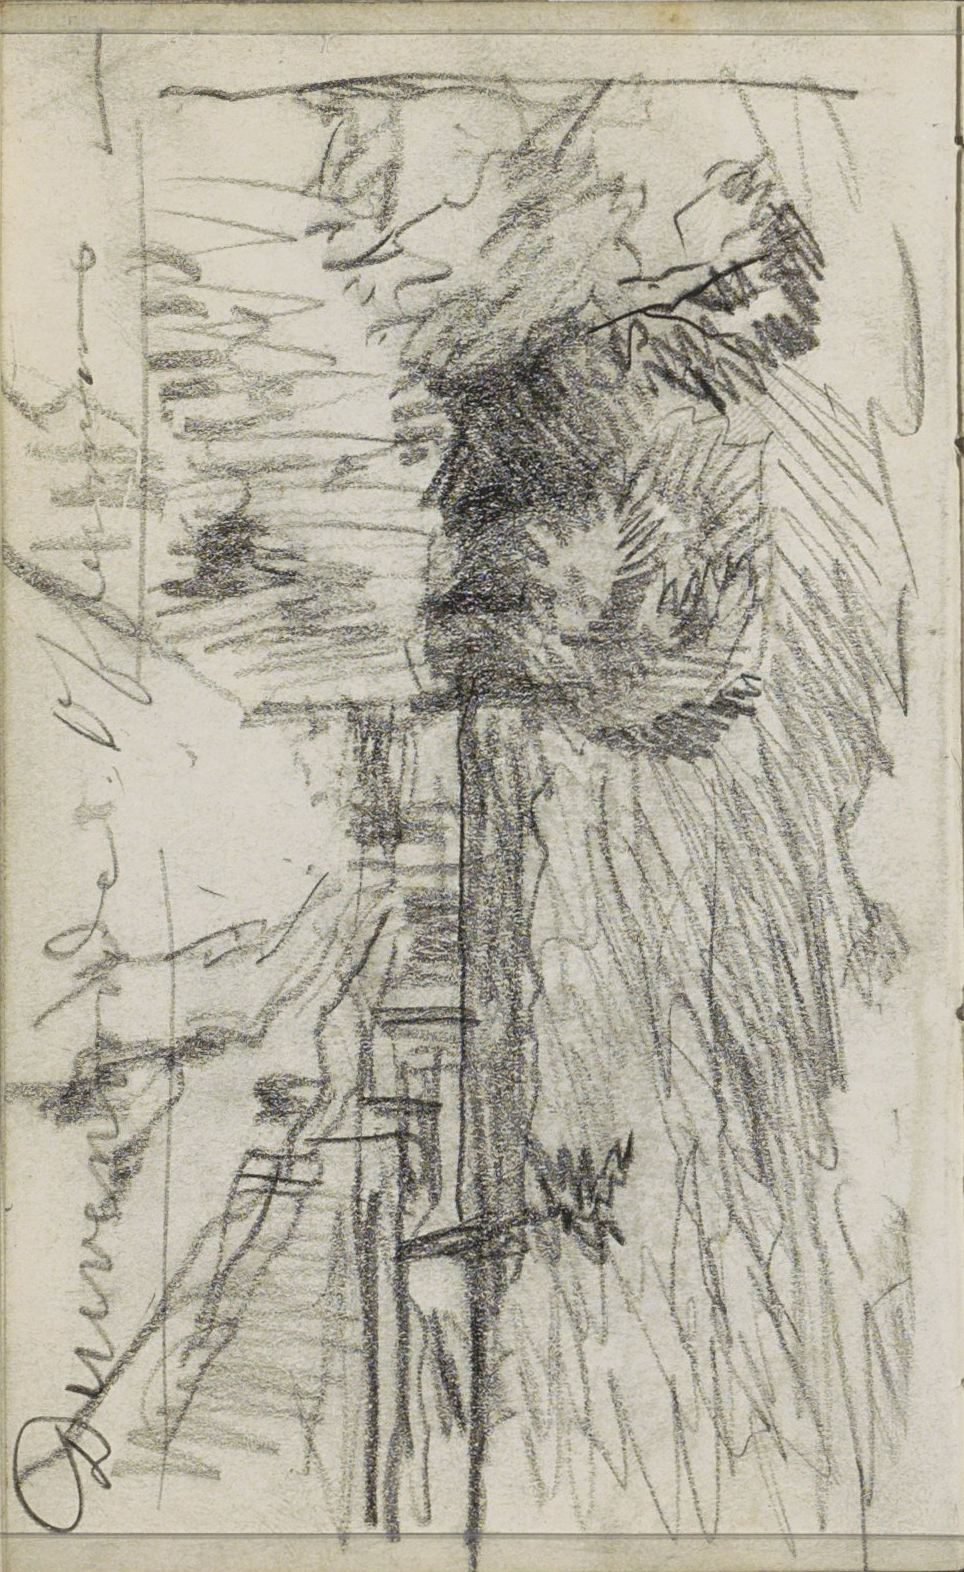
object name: sketchbook leaf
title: Landschap met een pad langs enkele bomen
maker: anton mauve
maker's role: draughtsman, painter, print maker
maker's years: 1838-1888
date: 1848-1888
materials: chalk, paper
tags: landscapes, road, path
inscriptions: annotation: ‘Duivenoorde Offermans’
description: Blad 11 verso uit een schetsboek met 53 bladen.